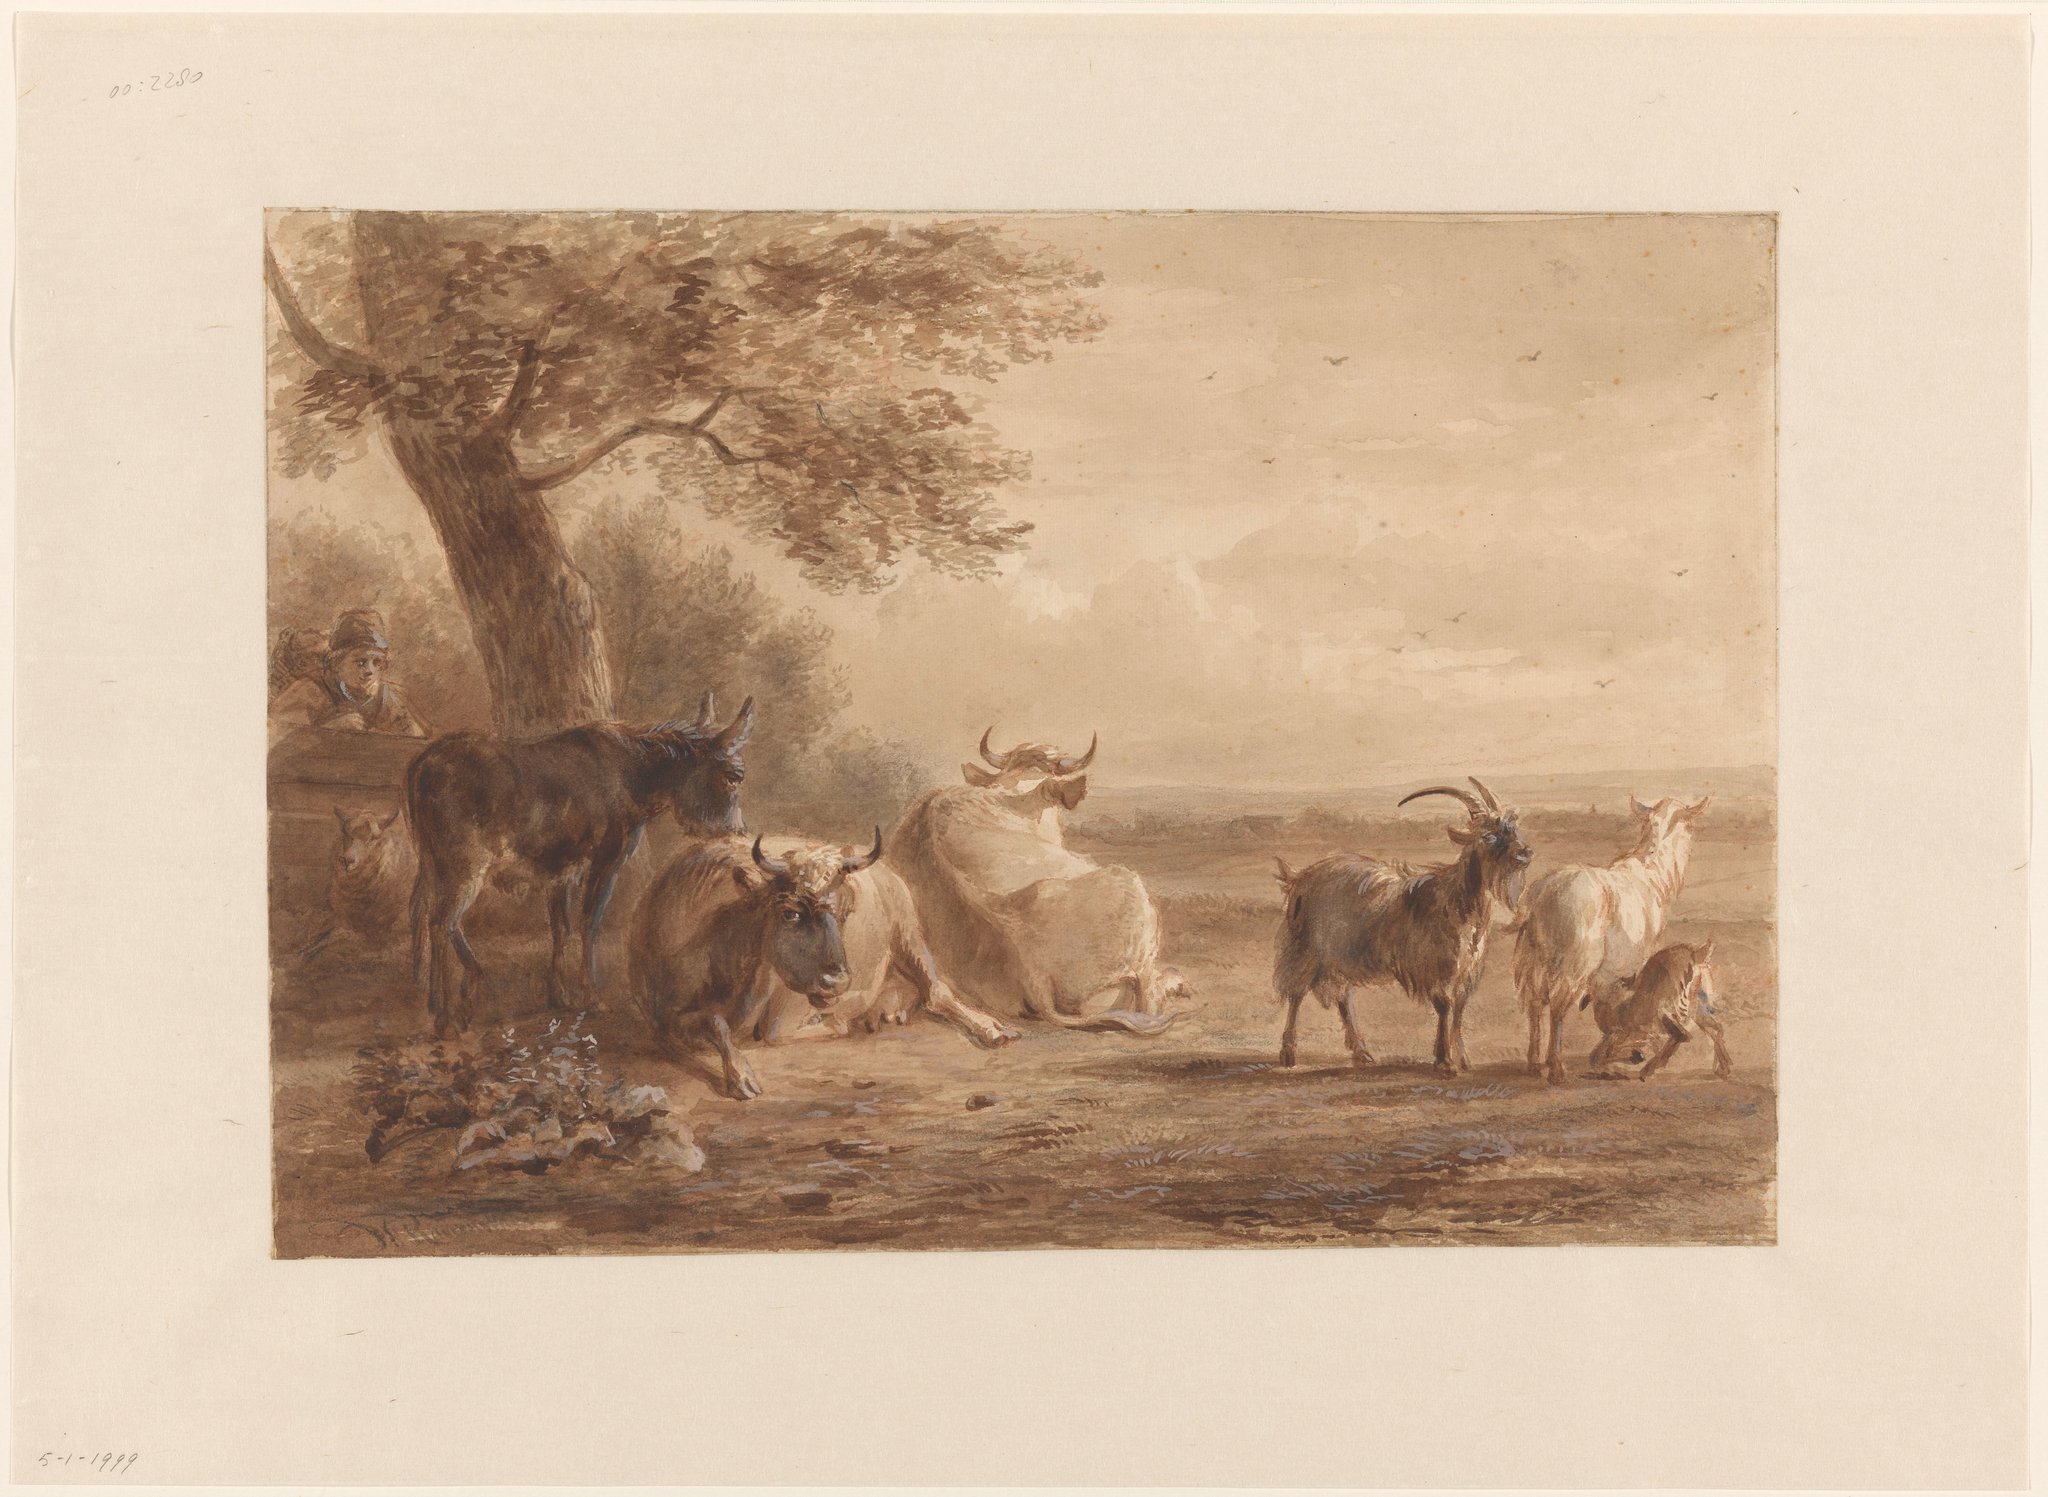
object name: drawing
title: Vee onder een boom en een man met een mand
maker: jan van ravenswaay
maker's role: draughtsman, painter, print maker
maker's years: 1789-1869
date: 1799-1869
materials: chalk, paint, paper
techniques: brush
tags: cow, ass, donkey, cattle, goat